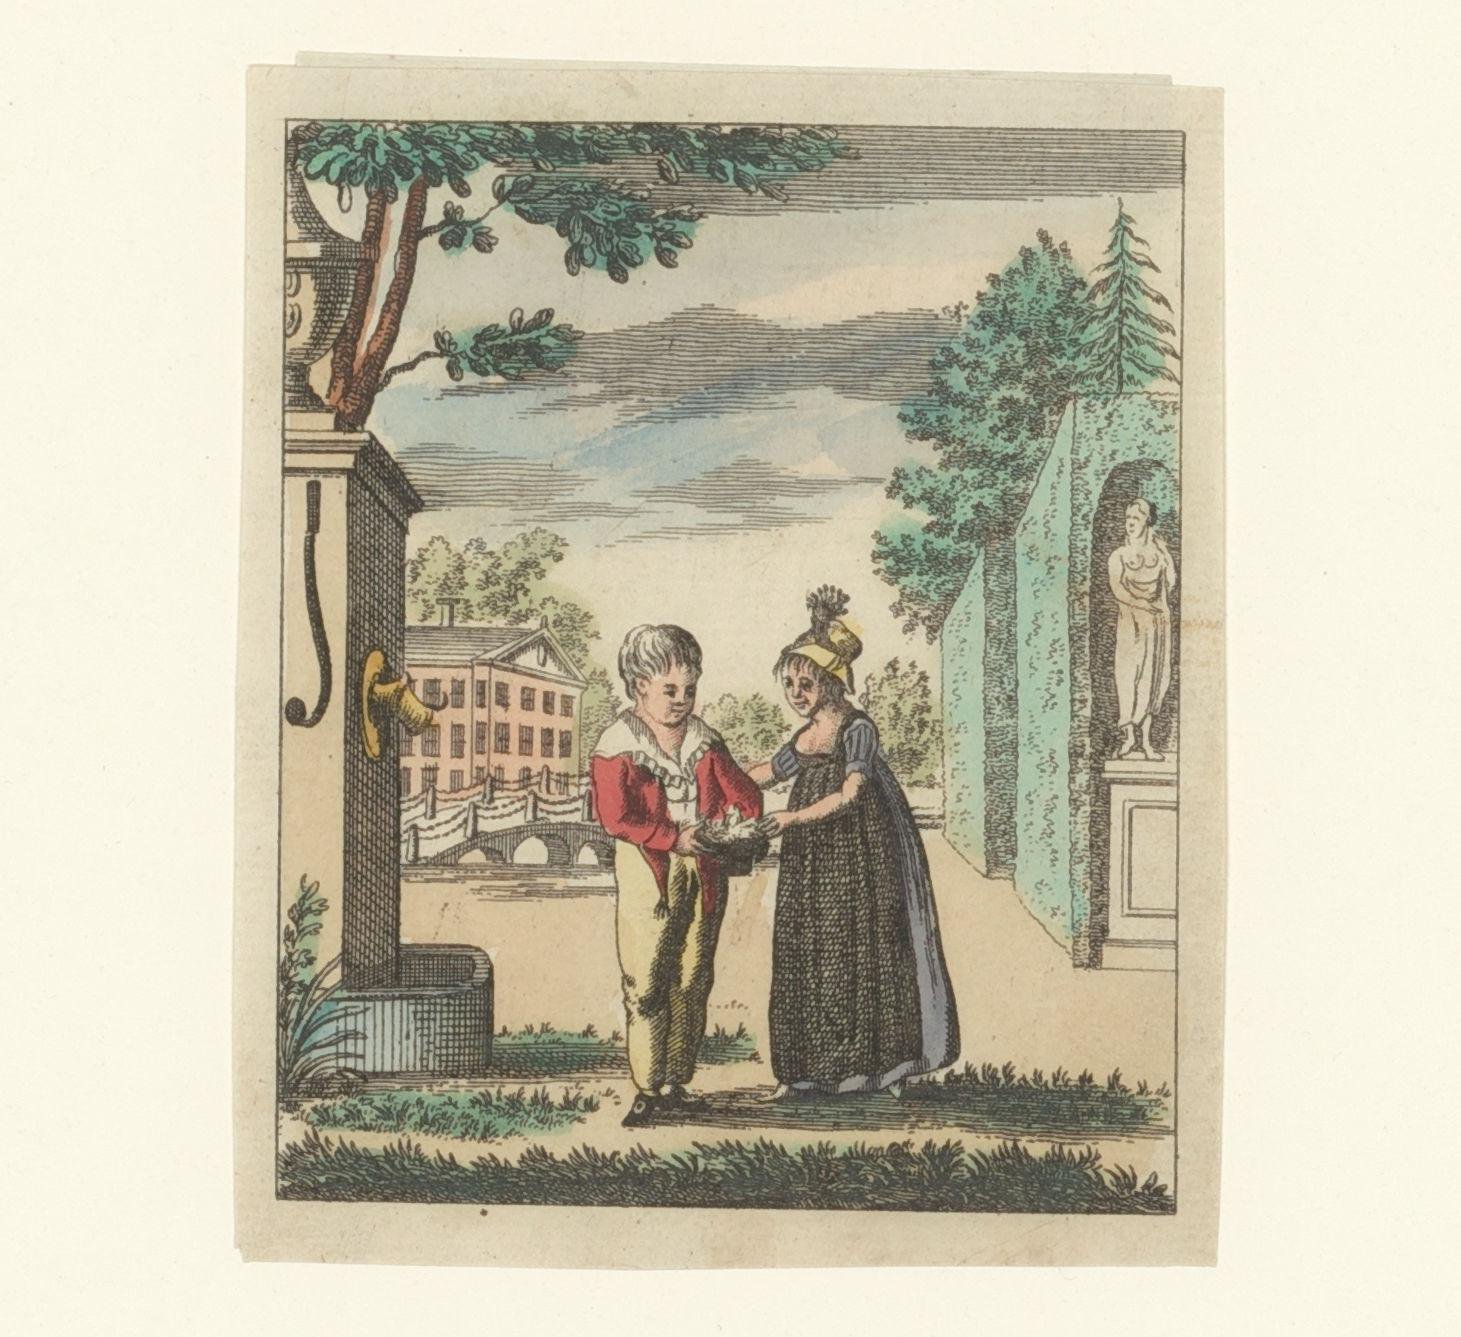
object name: print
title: Twee dames spelen met een nestje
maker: Anonymous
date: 1800-1899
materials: paper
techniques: etching, hand coloring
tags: hunting bird's eggs (children), girl (child between toddler and youth)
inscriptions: stamp, collector's mark: Lugt 1641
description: Onderwerpsrubrieken binnen de Atlas Zeden en Gewoonten: Zeden en Gewoonten in Engeren Zin, Des menschen beging, midden en einde, Kinderleven – Kinderspel en Kinderprenten.